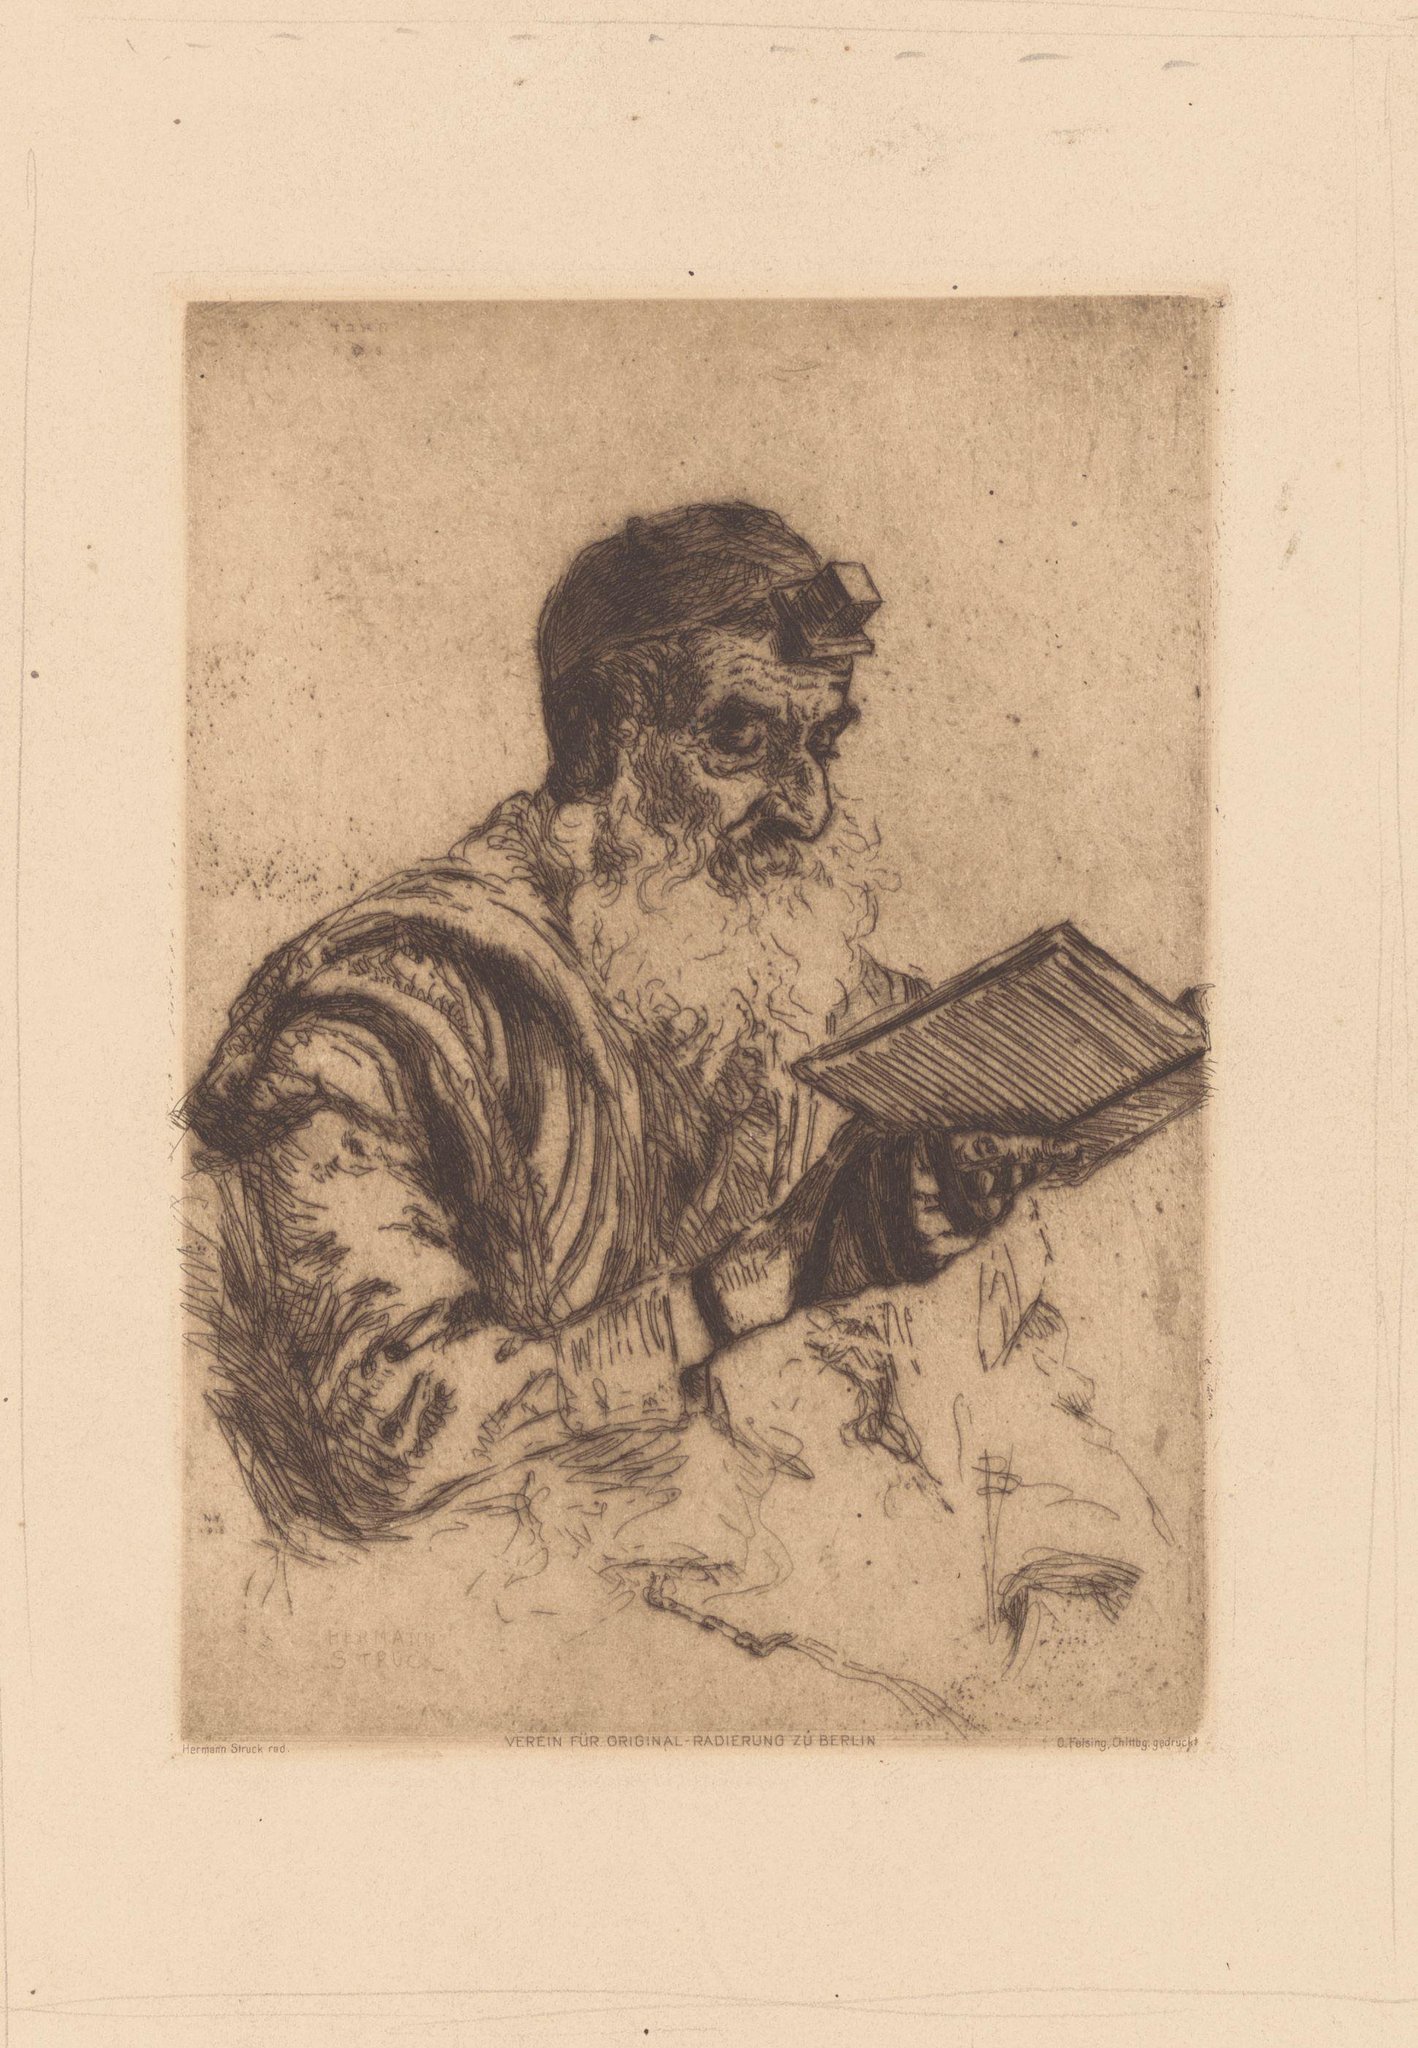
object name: print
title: Biddende joodse man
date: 1913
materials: paper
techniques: drypoint, etching, intaglio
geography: berlin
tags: 'tefillin', phylacteries ~ jewish ceremonial objects, 'tallit', prayer shawl worn over head and shoulders ~ jewish ceremonial objects, one person praying, the jews, jewish life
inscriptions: annotation: ‘Herman Struck la lecture’, collector's mark: Lugt 2228, annotation: ‘collall / werkwijze’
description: Portret van een biddende joodse man met in zijn rechterhand een gebedenboek. Hij draagt gebedsriemen, de tefilin, en een gebedskleed, de talliet.